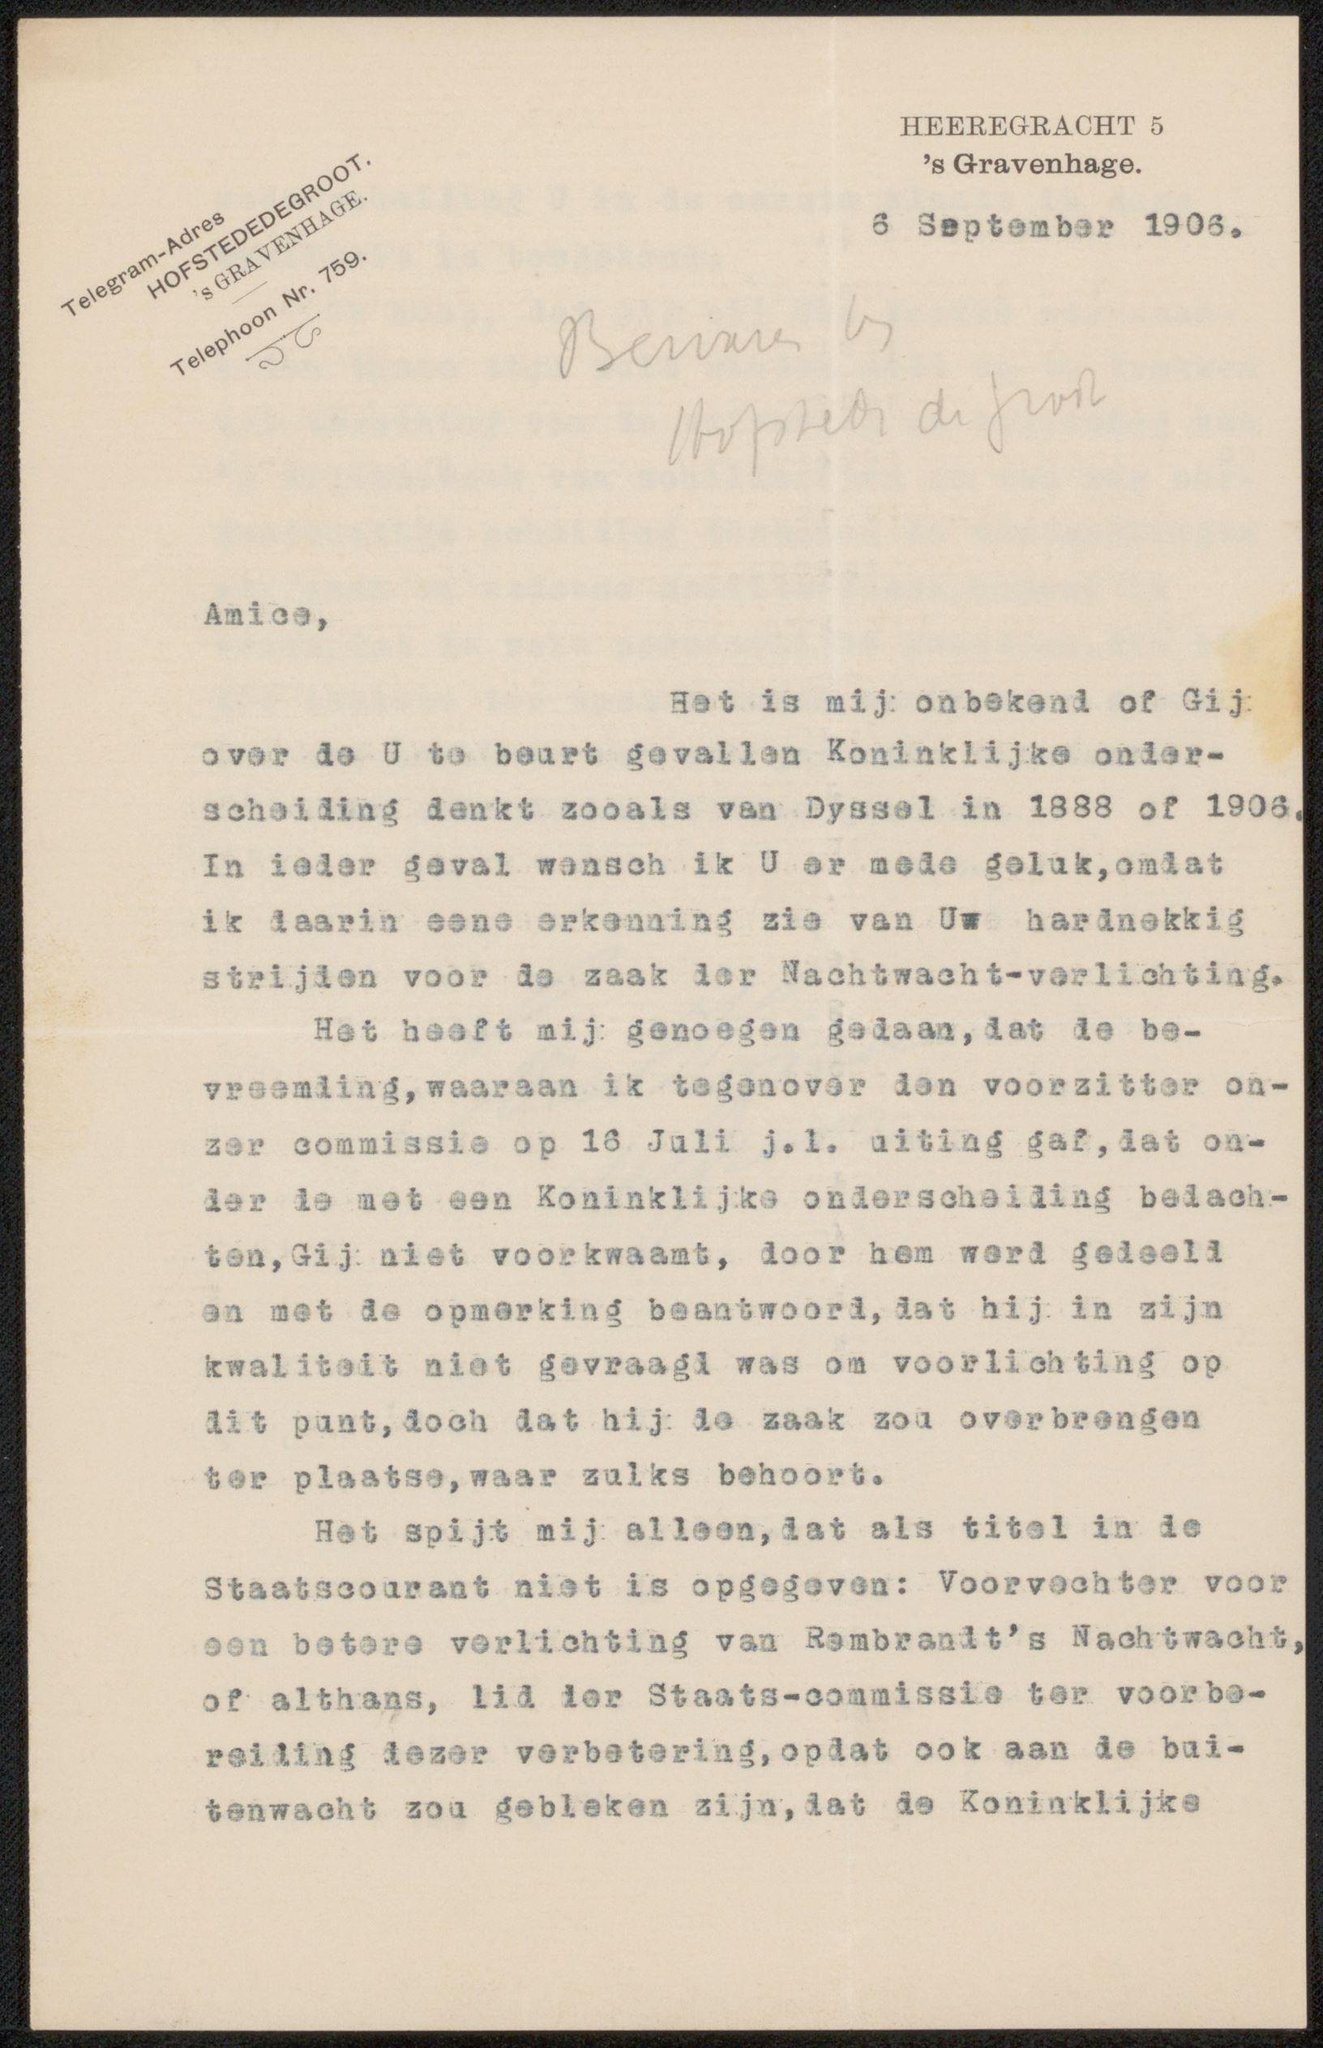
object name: letter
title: Brief aan Jan Veth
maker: cornelis hofstede de groot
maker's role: kunsthistoricus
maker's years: 1863-1940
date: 1906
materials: ink, paper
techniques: pen, printing, typewriting, writing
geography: the hague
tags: dordrecht, painter, print maker, draughtsman, designer, jan veth, leiden, rembrandt van rijn, lodewijk van deyssel, painting (including book-illumination, miniature-painting)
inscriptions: collector's mark: ‘RPK’